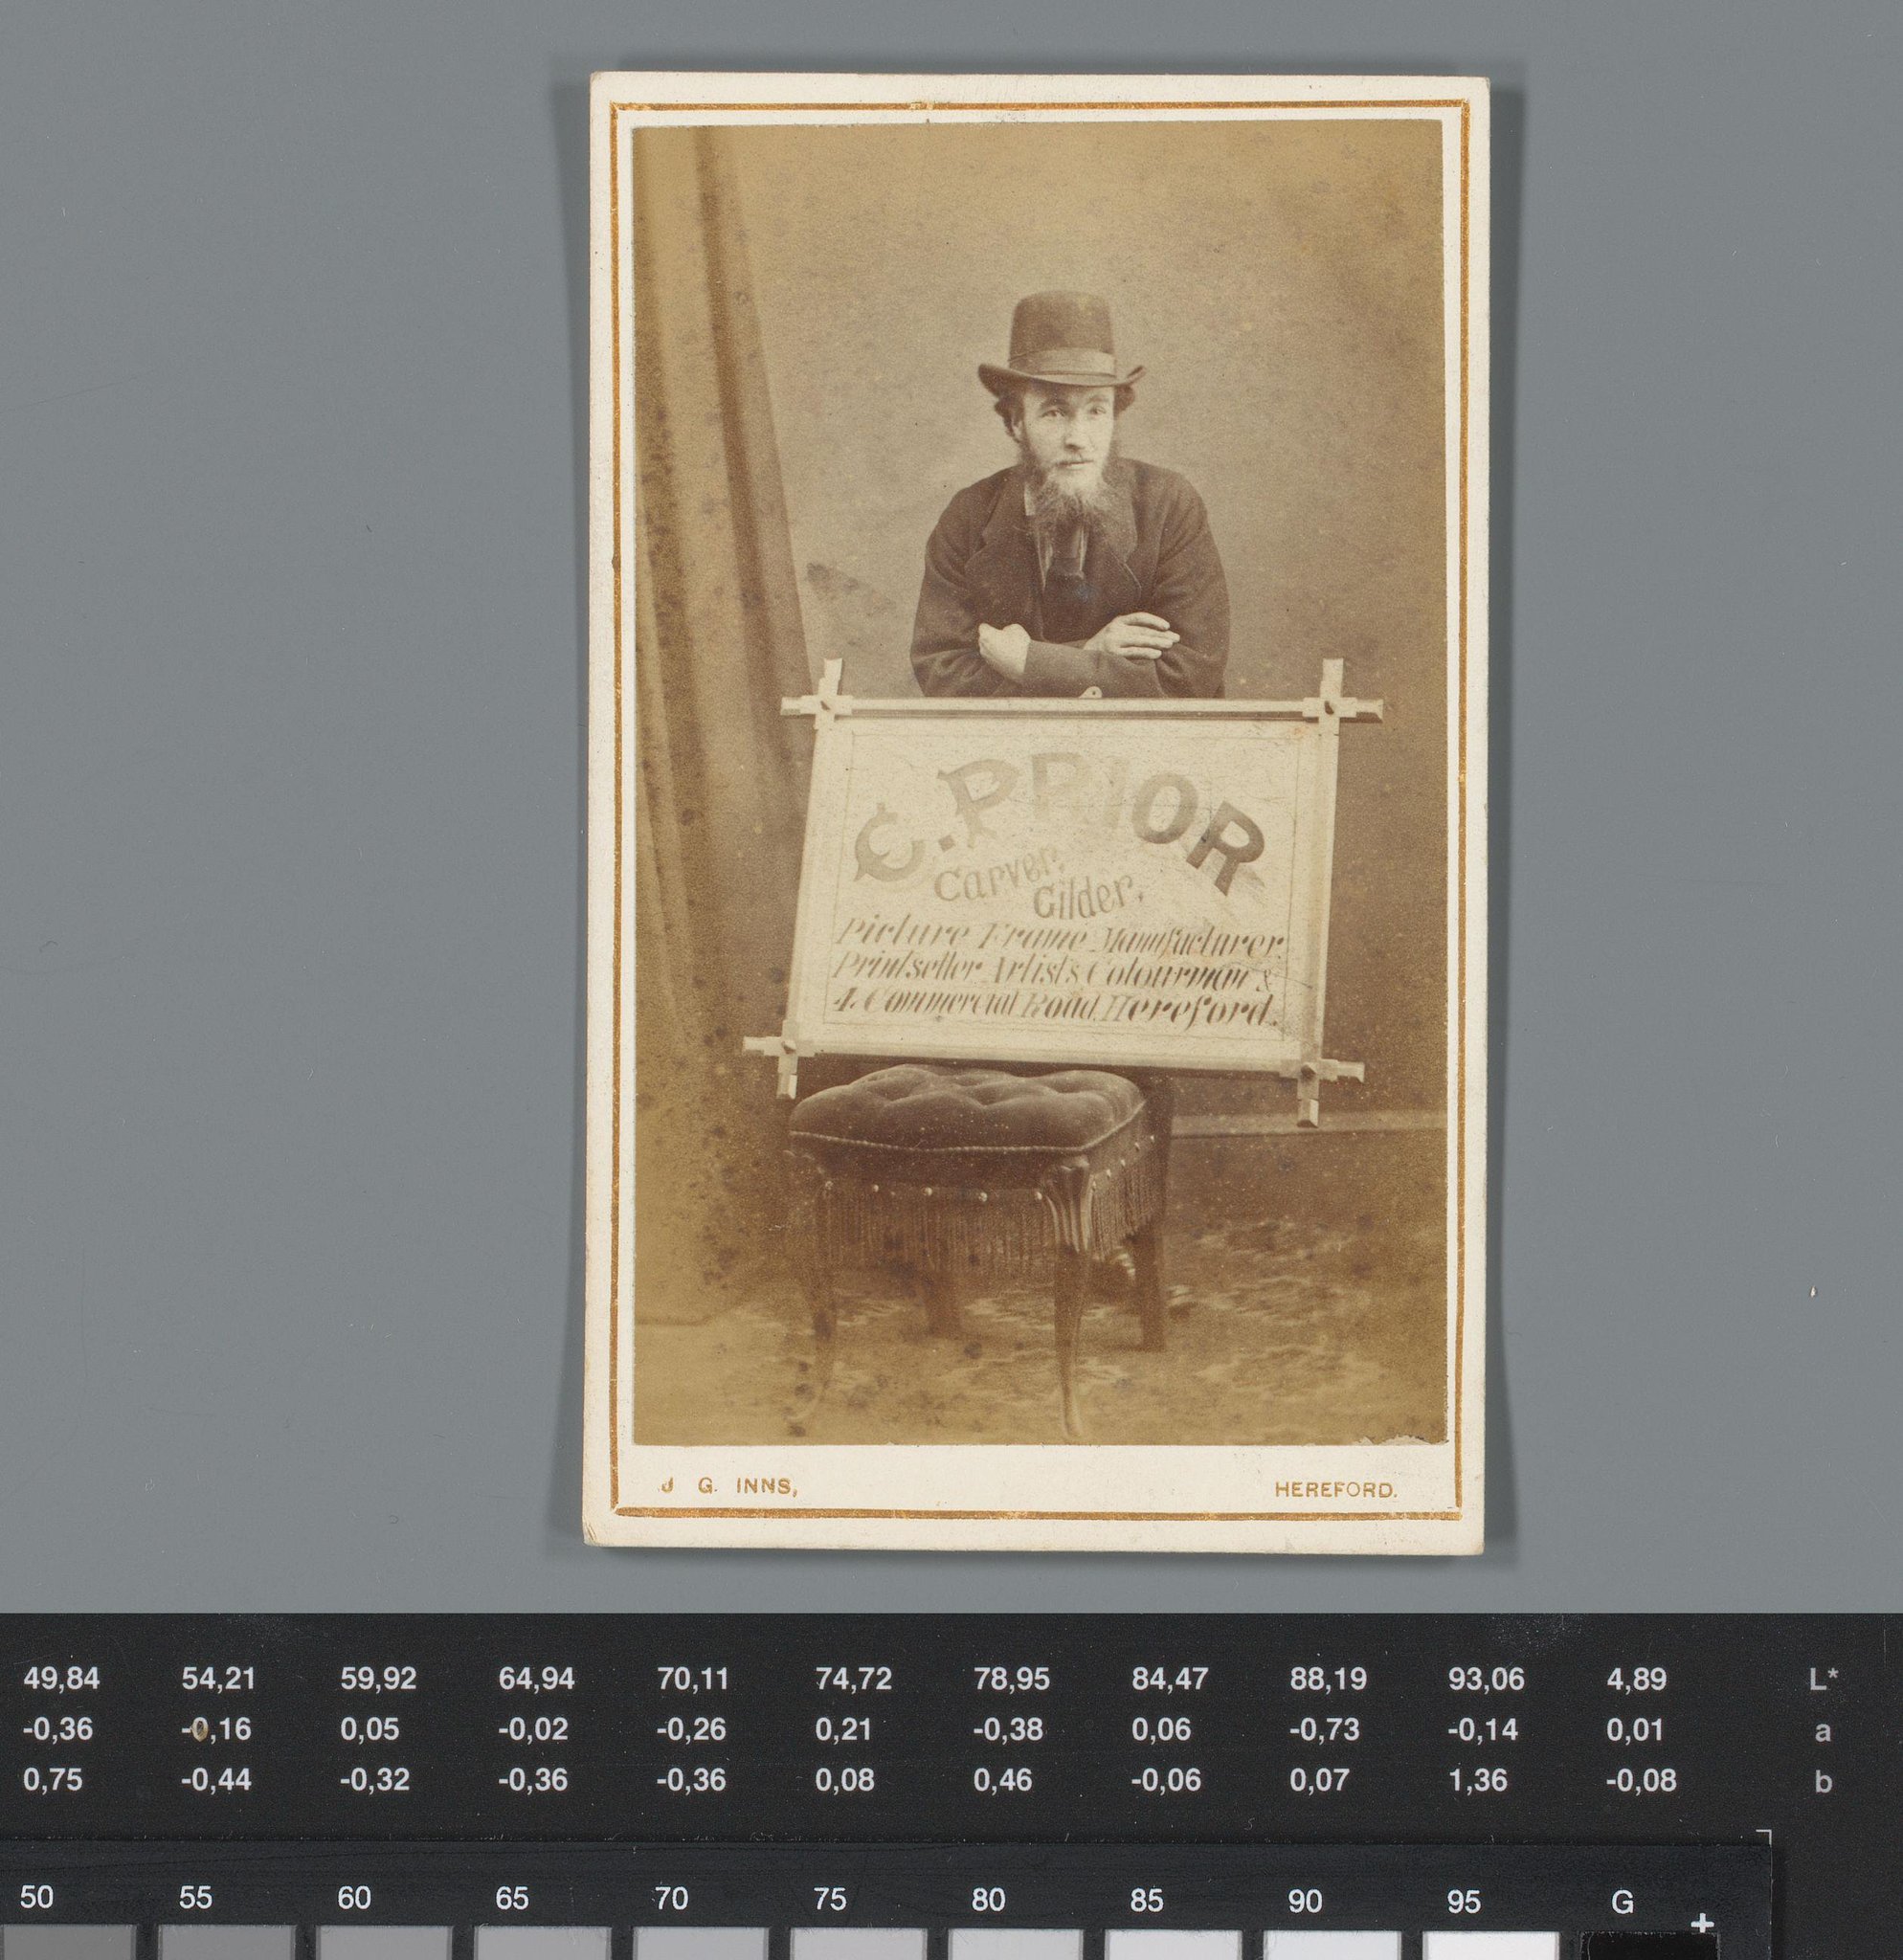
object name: carte de visite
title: Reclame voor fotograaf James G. Inns met een portret van lijstenmaker C. Prior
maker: james g. inns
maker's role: fotograaf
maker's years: 1846-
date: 1850-1915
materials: cardboard, photographic support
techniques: albumen print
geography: hereford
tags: c. prior, advertising, historical persons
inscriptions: inscription: ‘PHOTOGRAPHIC ARTIST, / James G. Inns - / 44. commercial rd / Hereford. / Copies may be had.’, inscription: ‘C. PRIOR /Carver, Gilder / Picture frame Manufacturer (...) Hereford.’